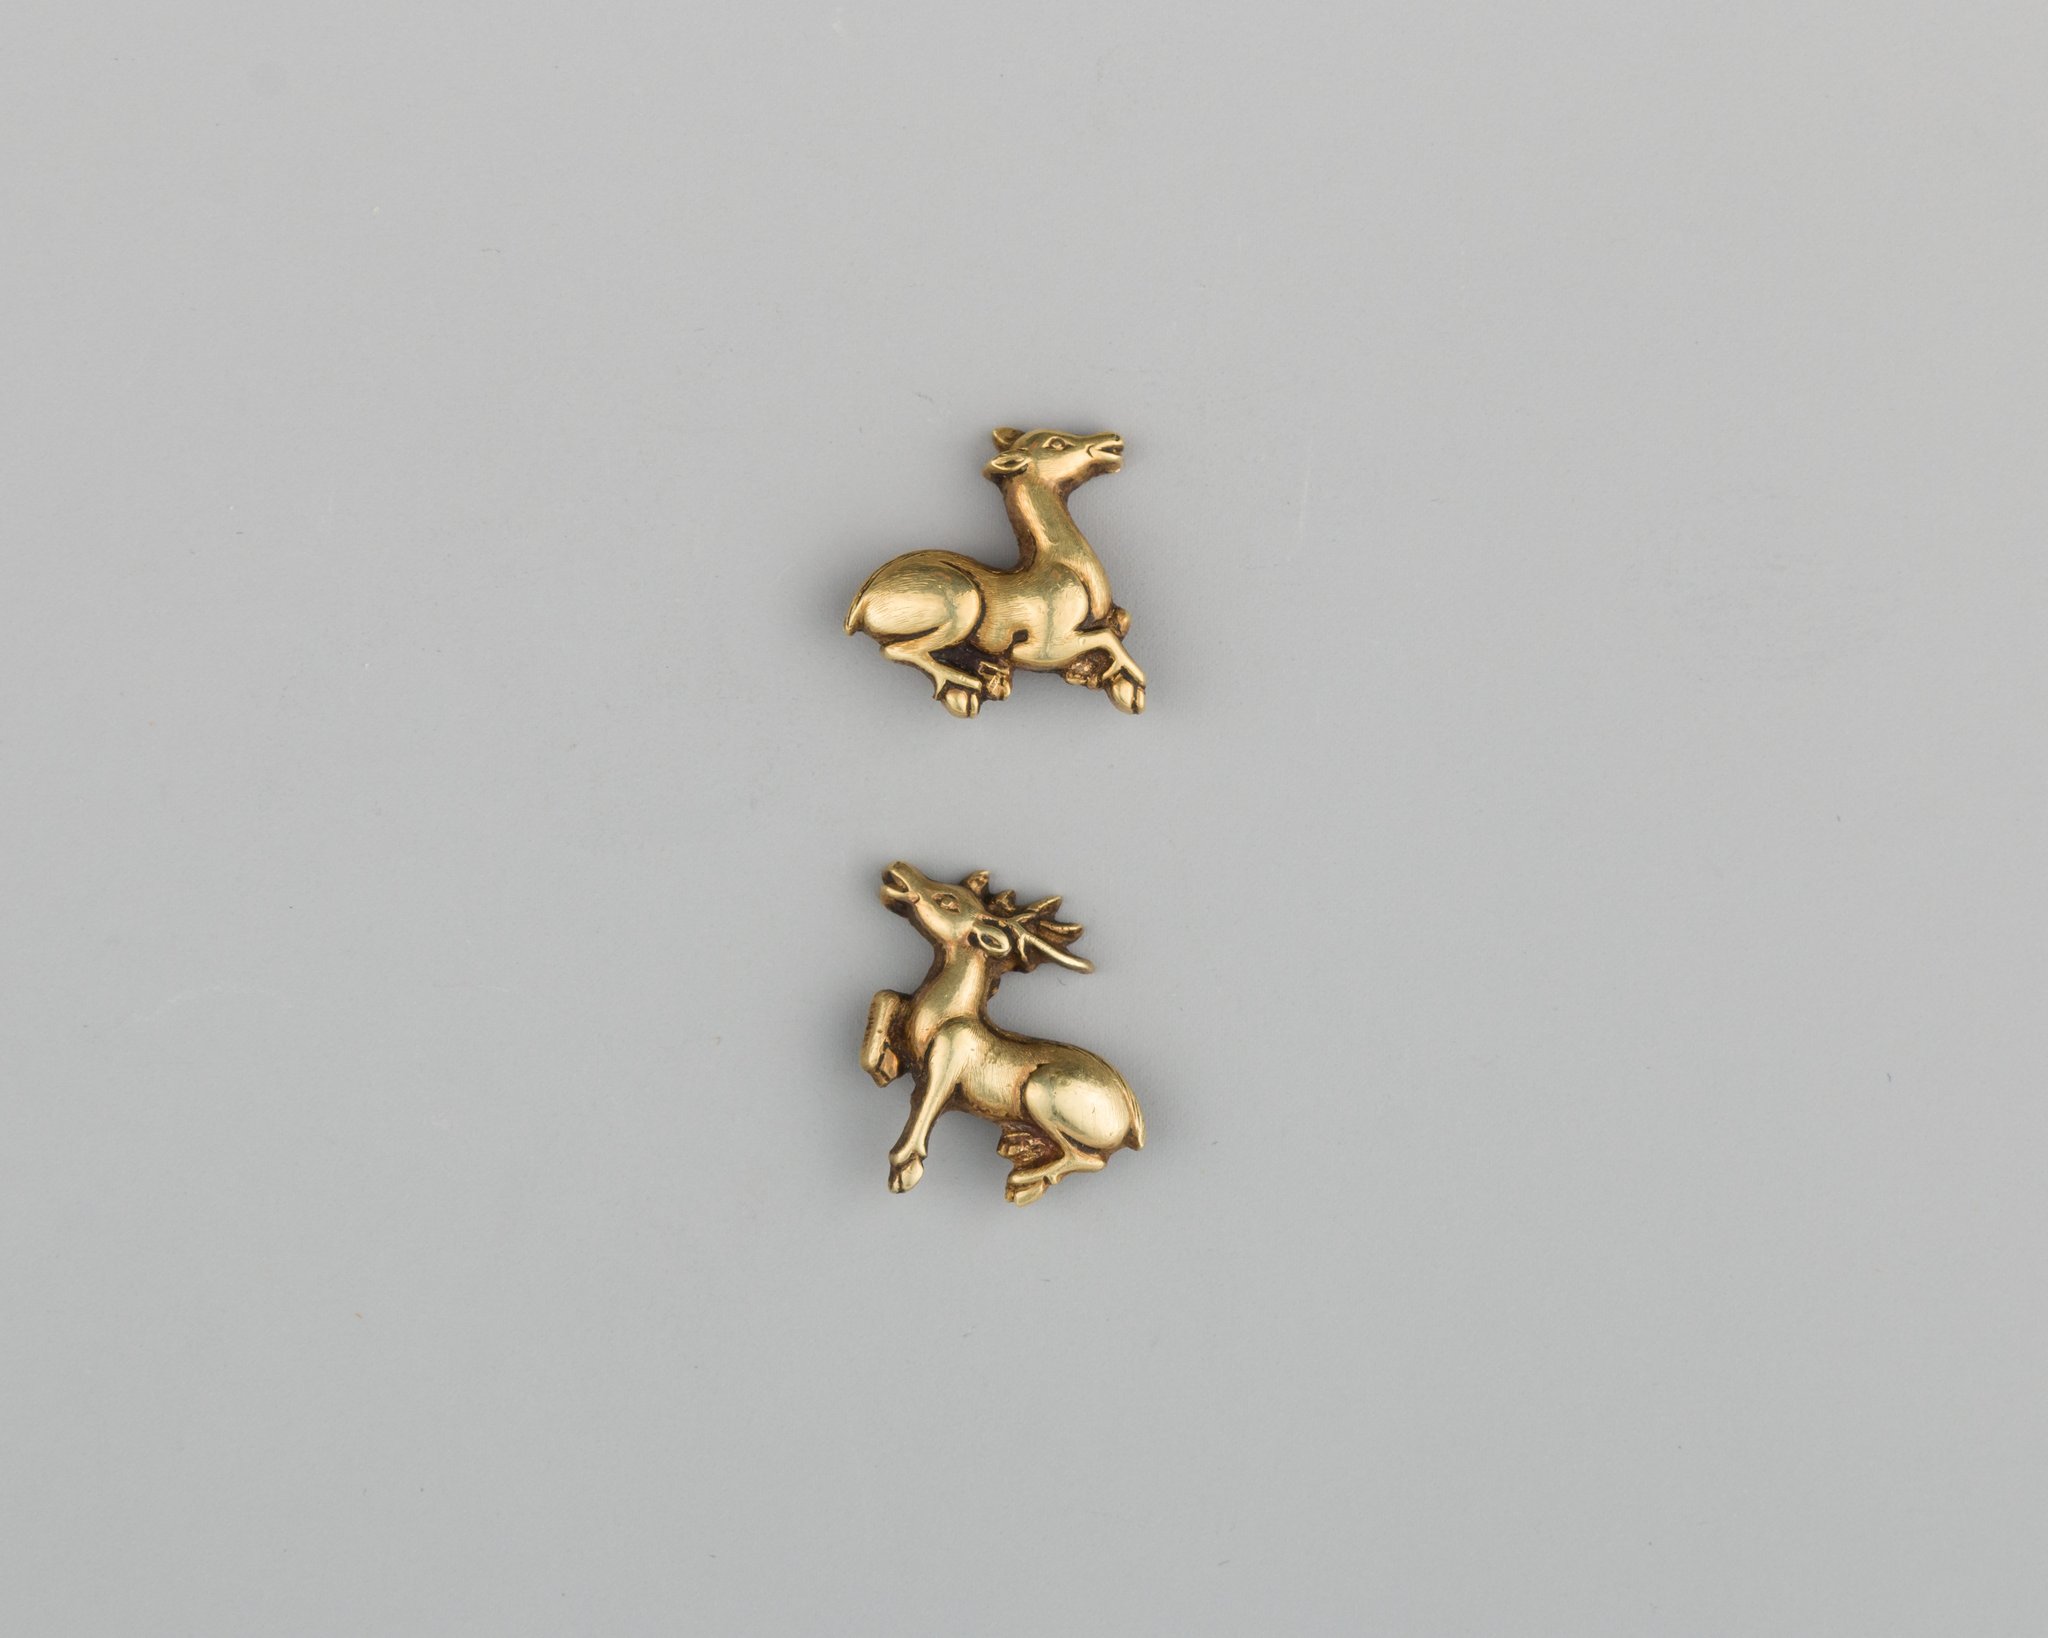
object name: pair of sword grip ornament menuki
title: Pair of Sword-Grip Ornaments (Menuki)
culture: japanese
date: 1701-1800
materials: gold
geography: japan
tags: deer